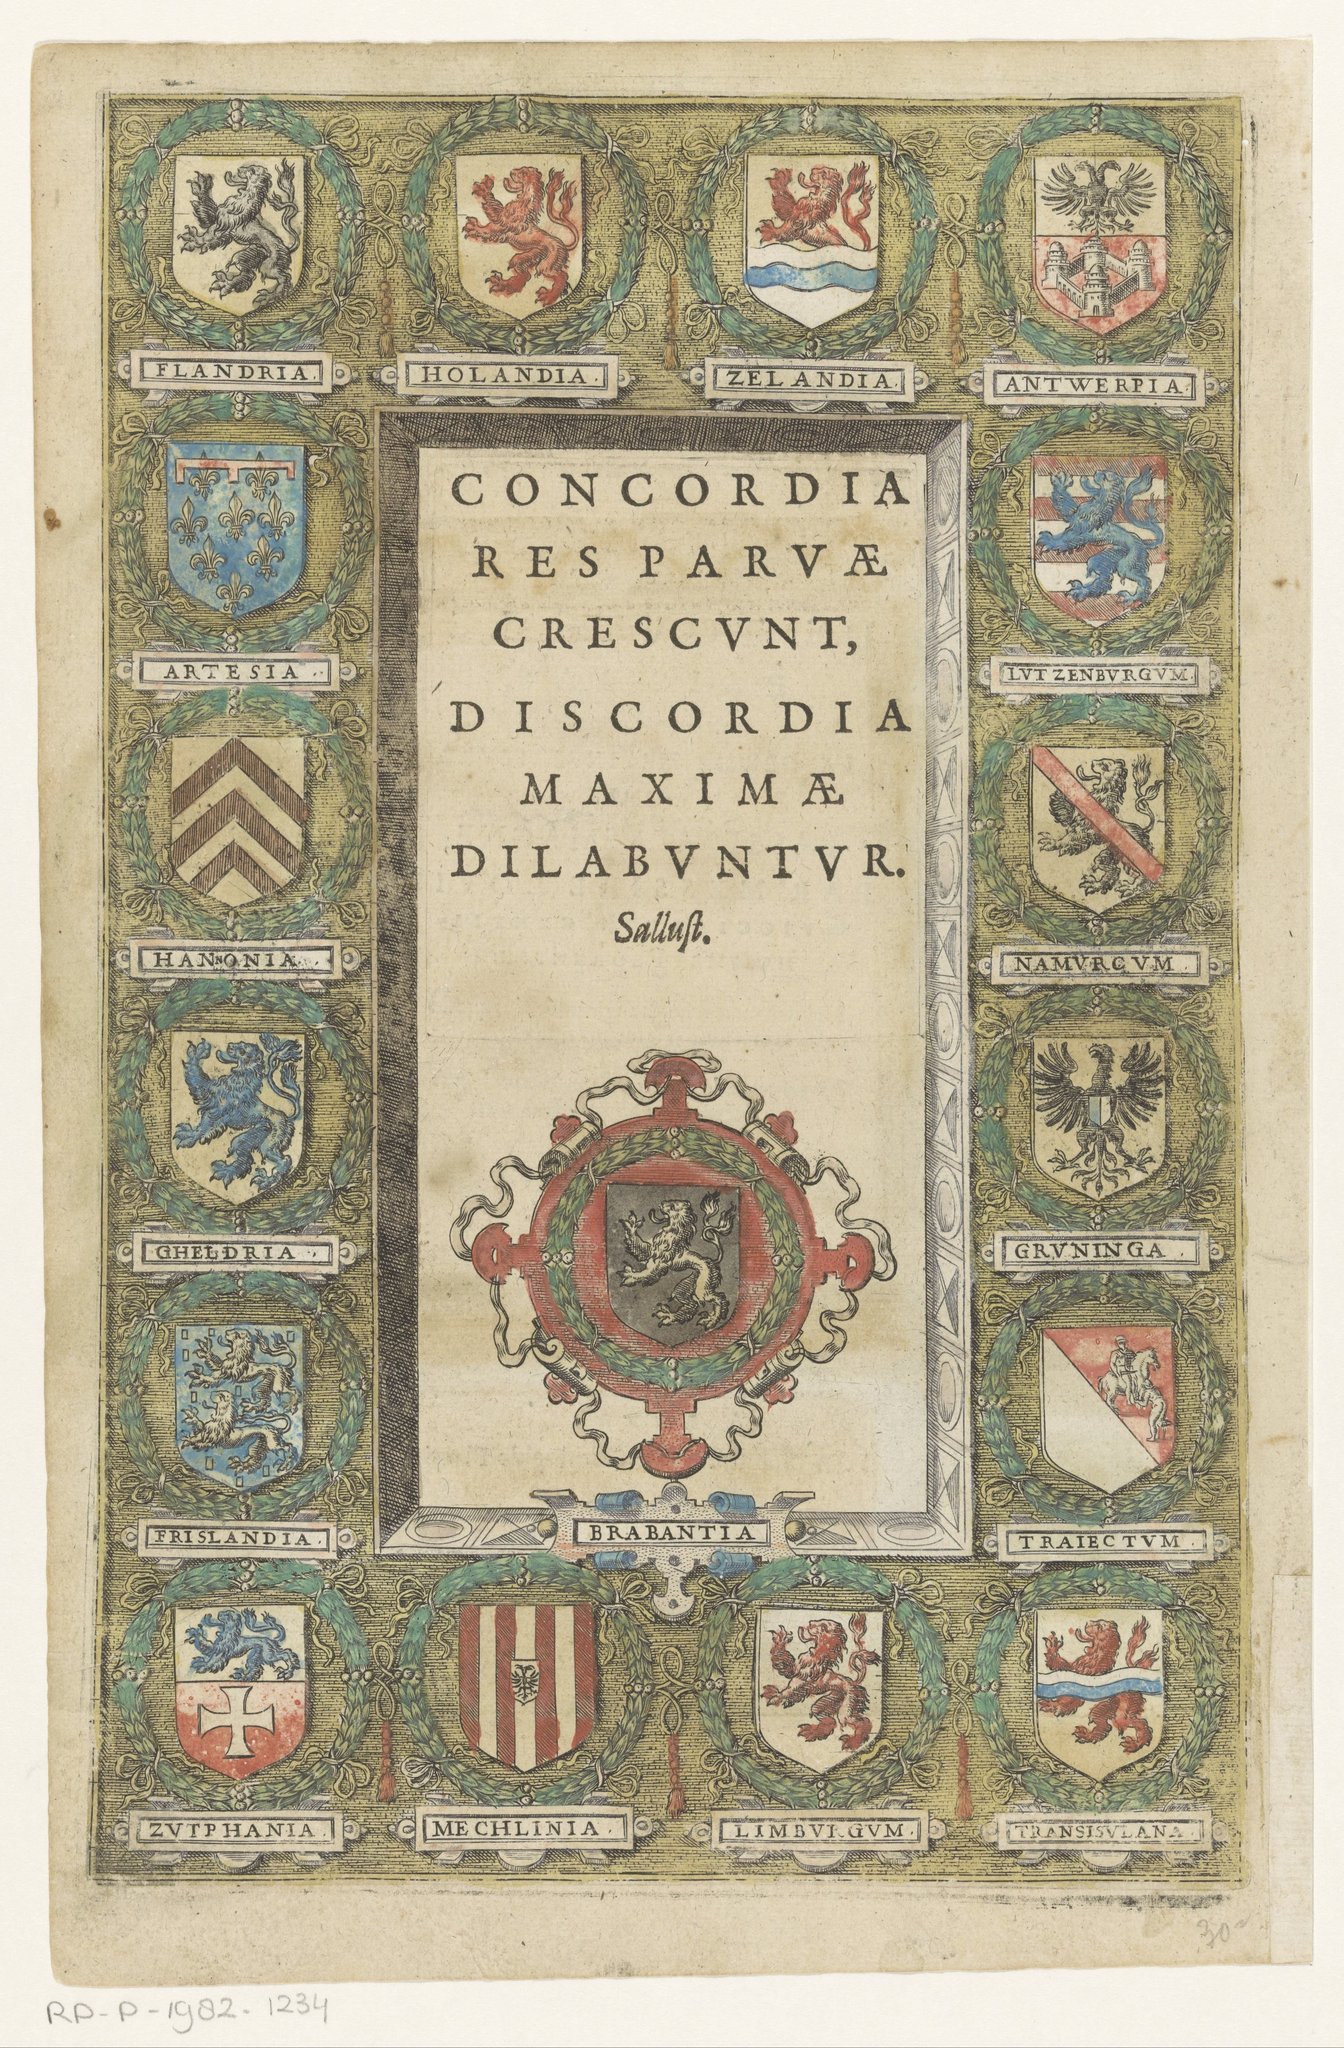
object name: book illustration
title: Wapens van de Zeventien Provinciën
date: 1582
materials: paper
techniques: engraving, hand coloring, letterpress printing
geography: antwerp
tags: coat of arms (as symbol of the state, etc.)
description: In het midden het wapen van de provincie Brabant en een Latijnse tekst. Rondom een rand met wapens van de overige zestien Provinciën van de Habsburgse Nederlanden.